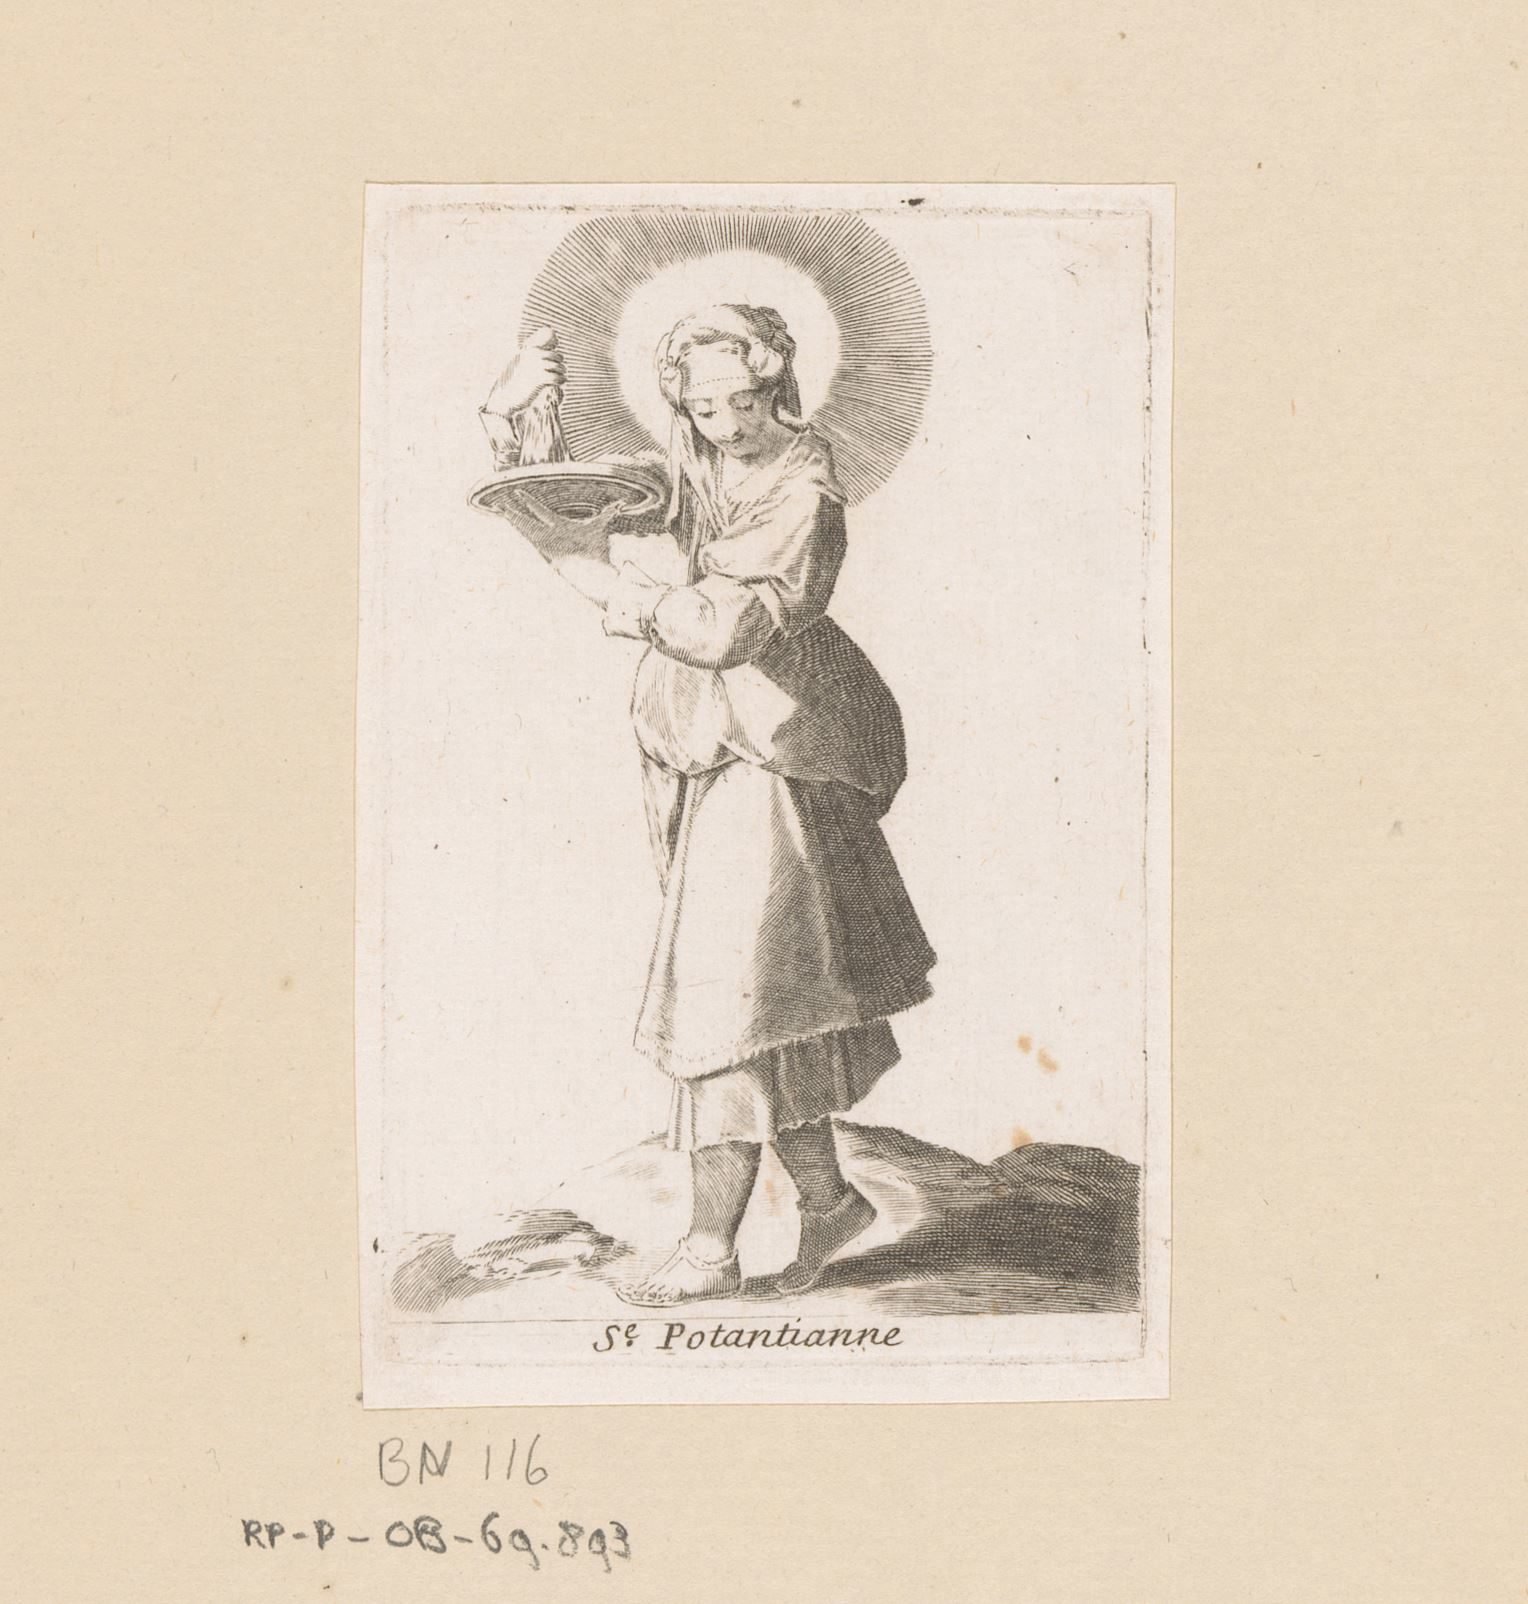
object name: print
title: H. Potantianna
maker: claude mellan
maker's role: draughtsman, print maker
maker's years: 1598-1688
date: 1608-1688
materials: paper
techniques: engraving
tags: female saints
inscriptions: collector's mark: Lugt 240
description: Maakt mogelijk deel uit van een serie met verschillende heiligen.